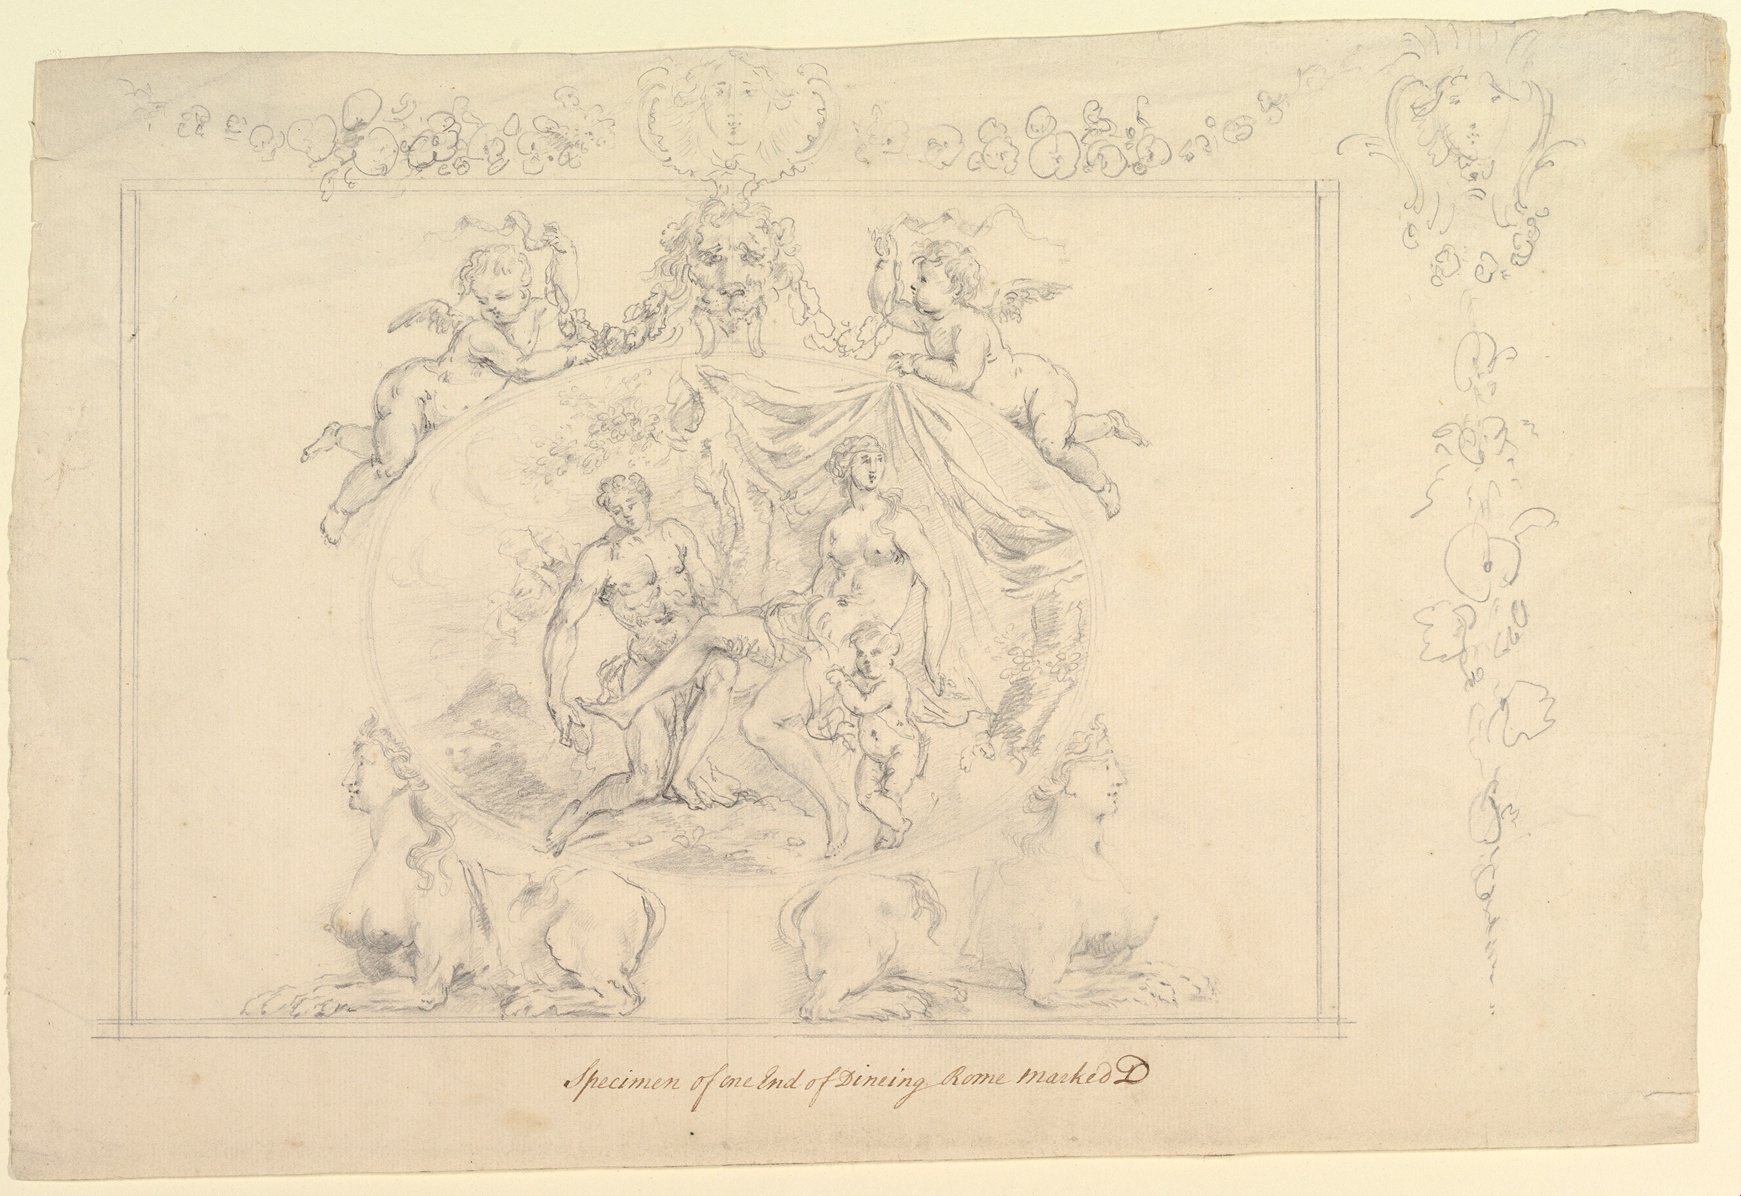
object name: drawing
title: Design for the painting, Mars, Venus & Cupid for the Dining Room at Kirtlington Park, Oxfordshire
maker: john sanderson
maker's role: artist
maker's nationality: british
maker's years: 1730-1774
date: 1747-1748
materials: graphite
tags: cupid,mars,venus